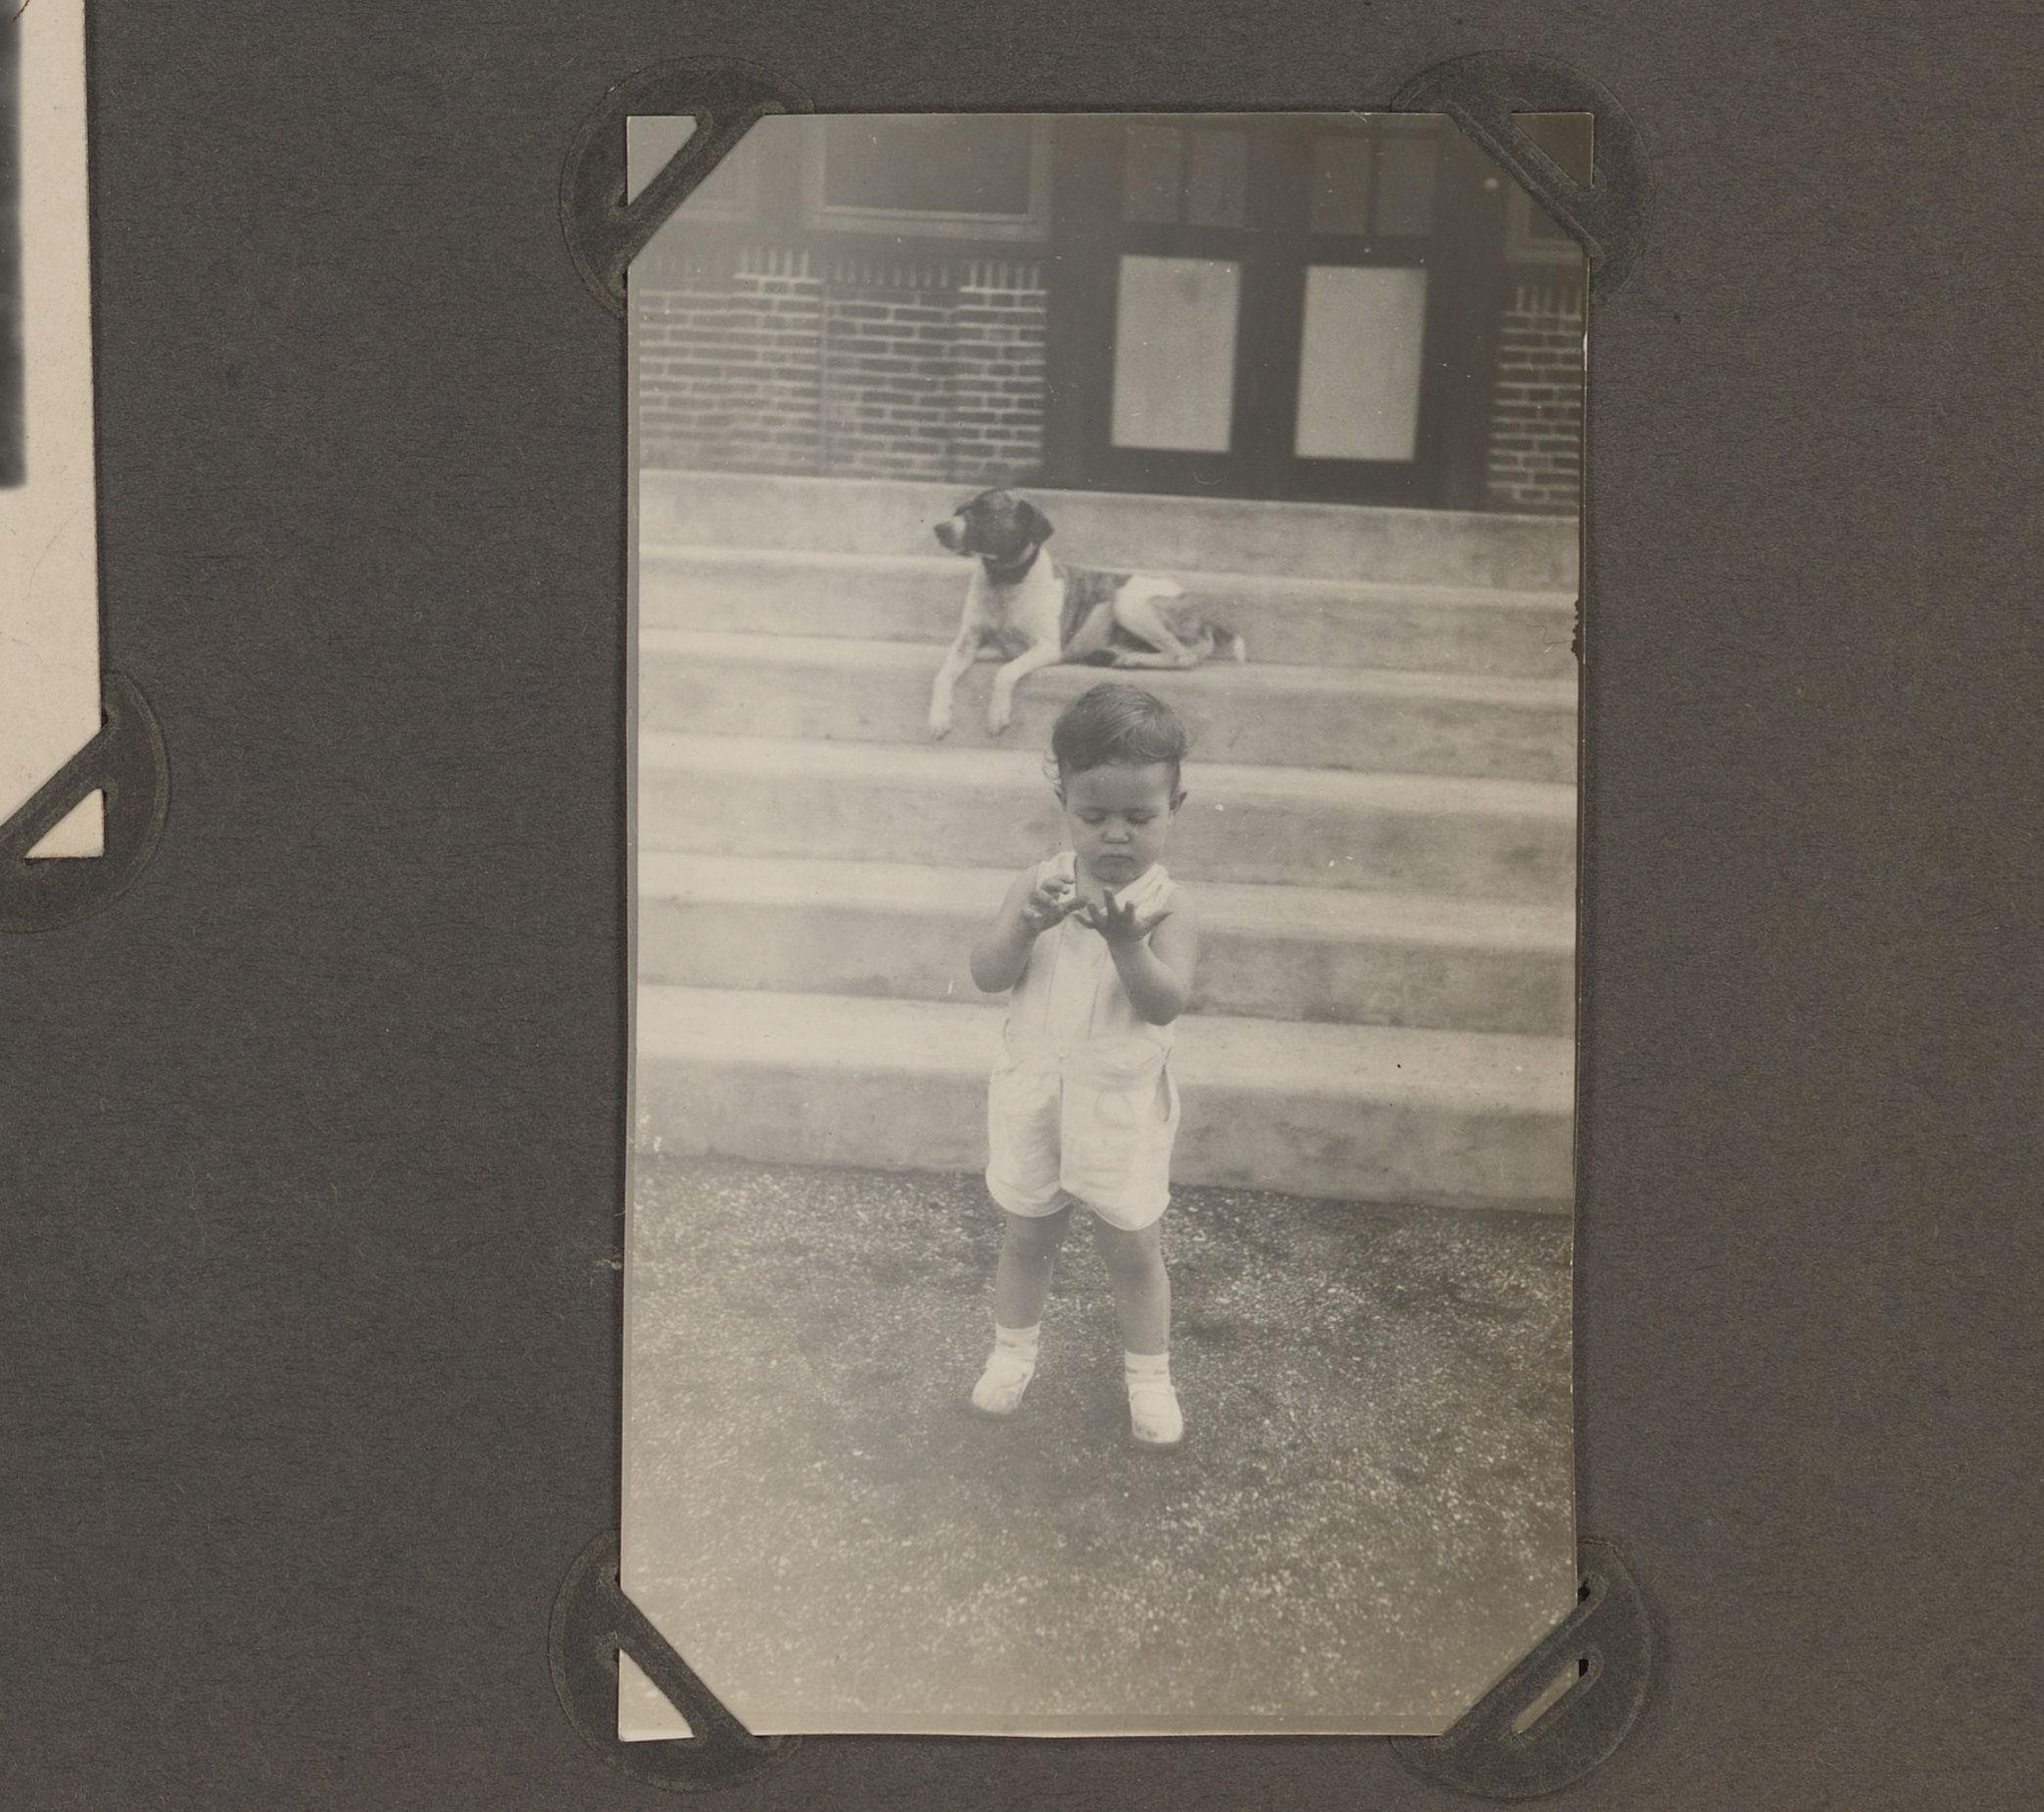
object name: photograph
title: Familiefoto van het gezin Jetten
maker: Anonymous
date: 1925-1927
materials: photographic support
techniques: photography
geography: suriname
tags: jetten, familie, moengo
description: Familiefoto van de kinderen Jetten. Foto op een bladzijde van een los albumblad. Onderdeel van het ensemble met foto's van de familie van ingenieur Jetten in de mijnbouwstad Moengo in Suriname.